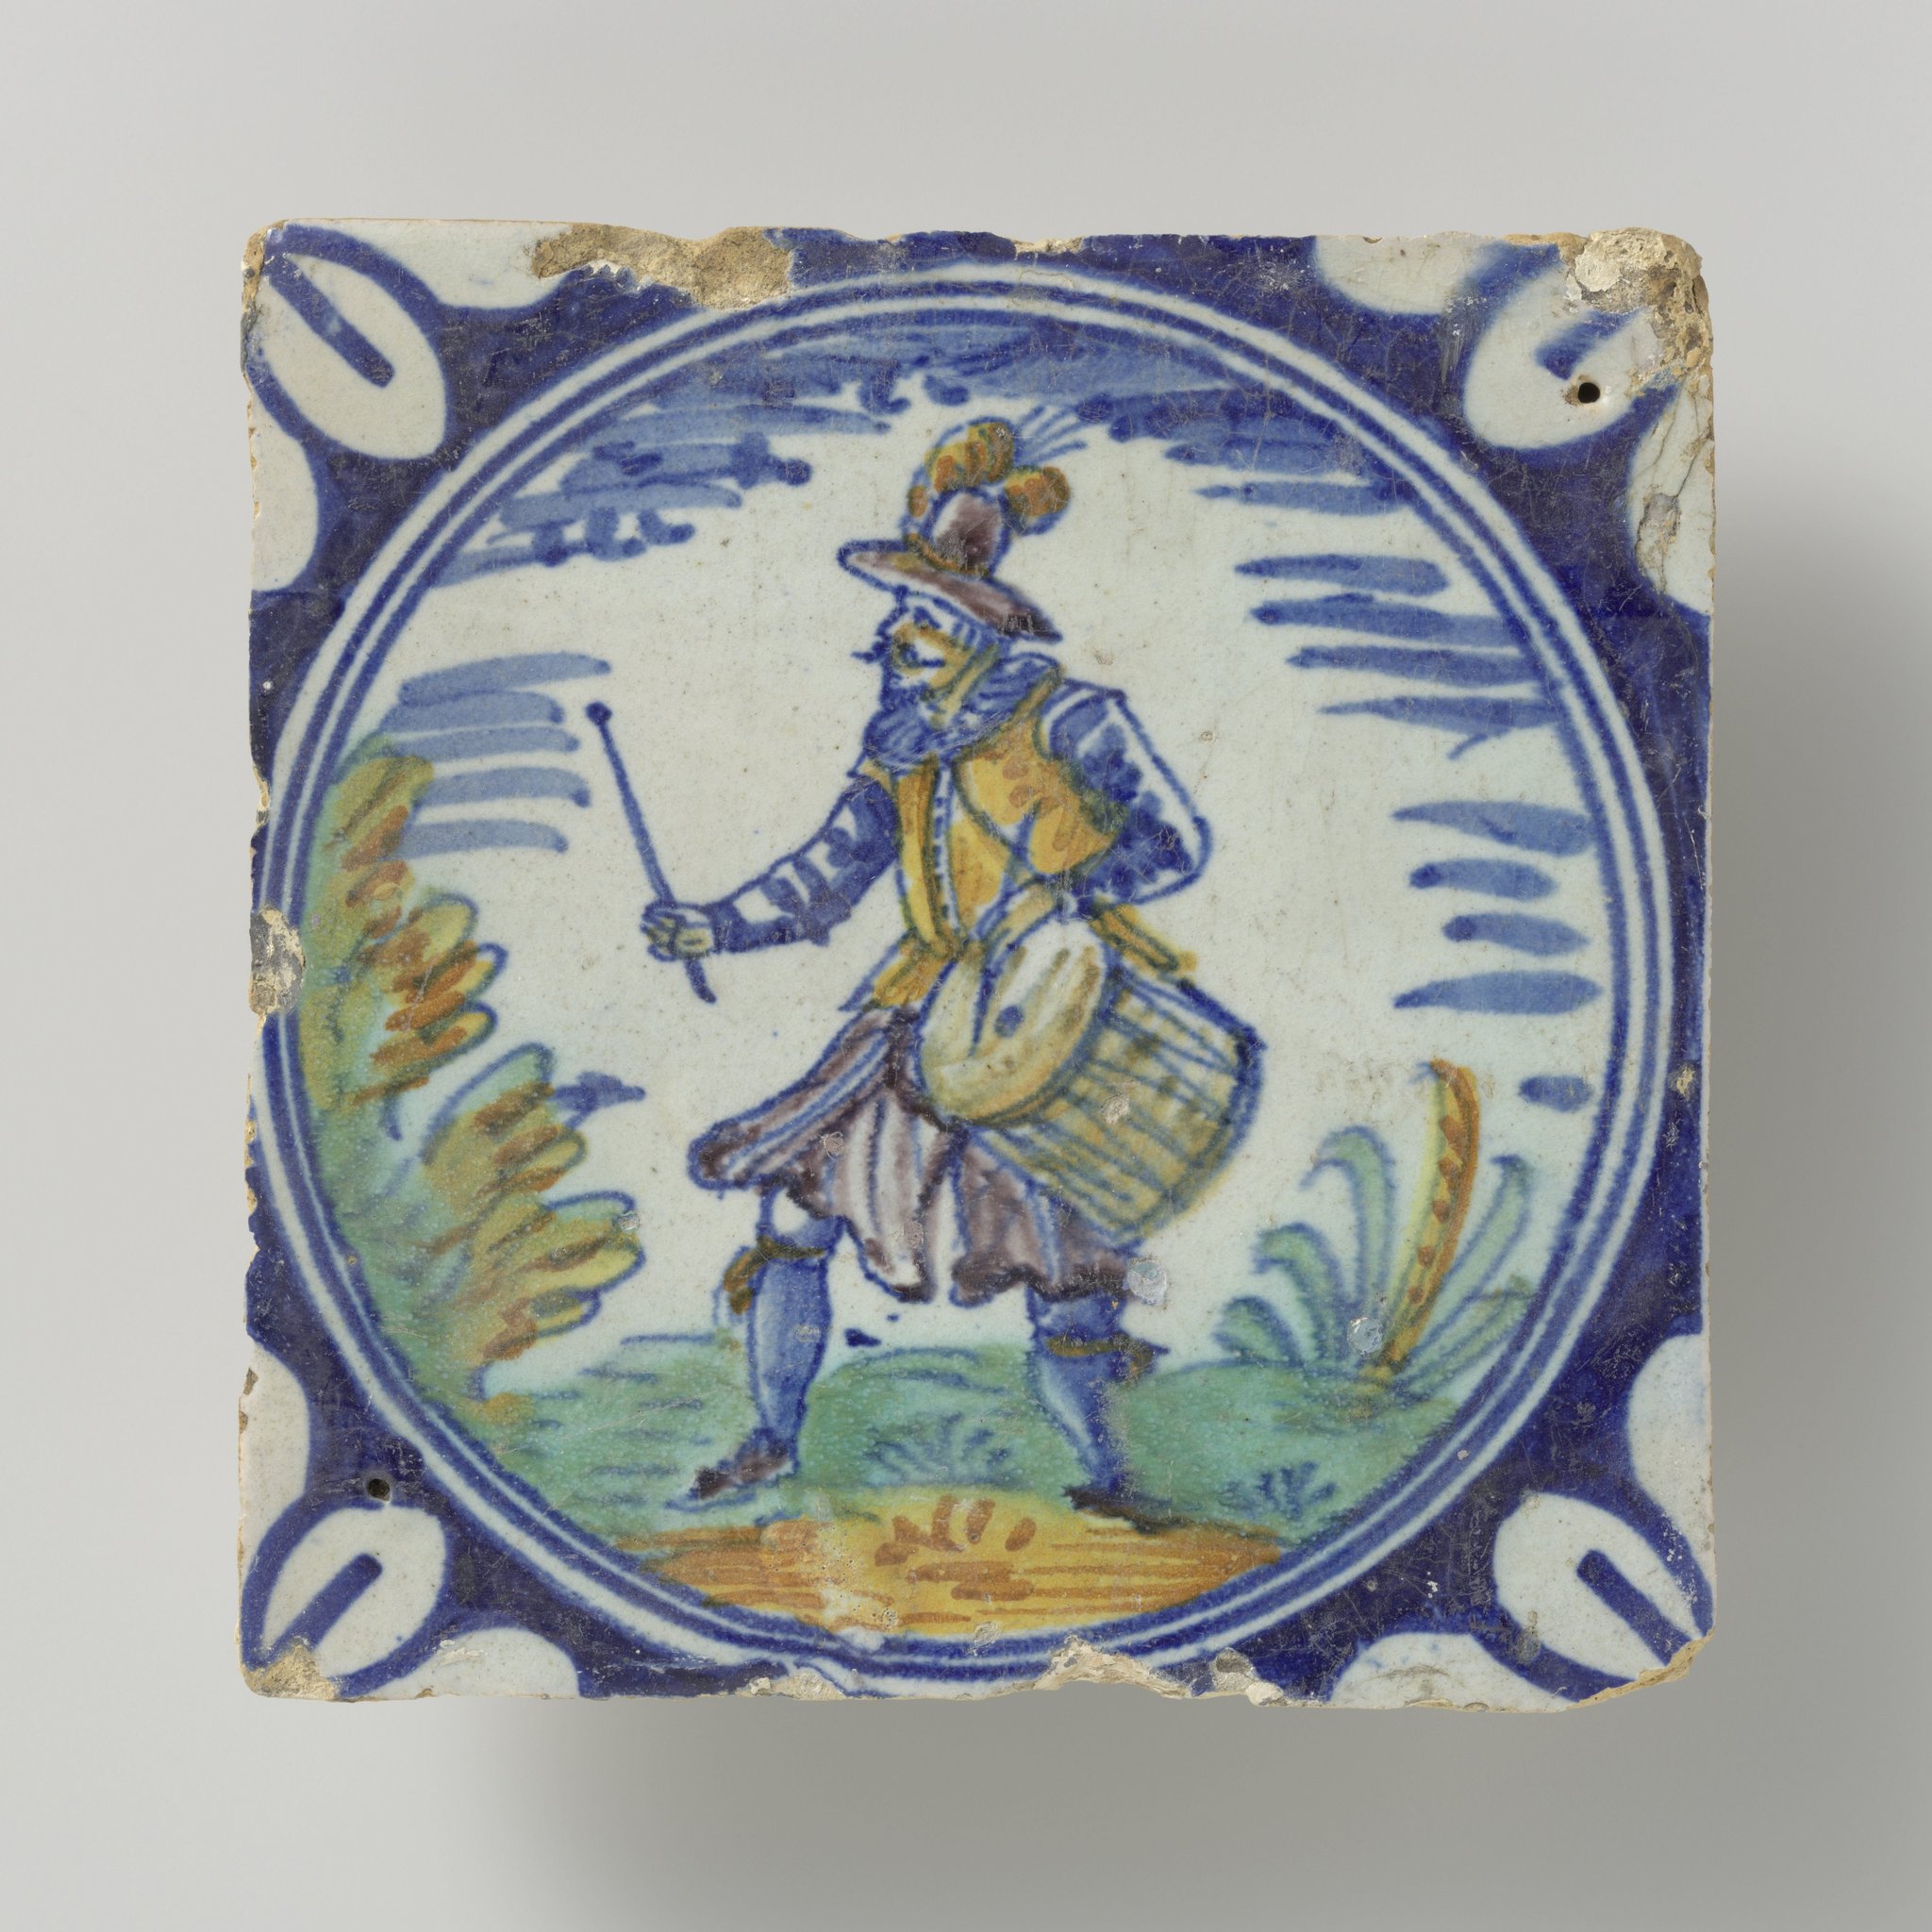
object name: tile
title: Tegel, veelkleurig beschilderd met een soldaat of een vaandeldrager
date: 1625-1700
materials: earthenware, glaze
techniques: maiolica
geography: netherlands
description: Tegel, veelkleurig beschilderd met een soldaat of een vaandeldrager.